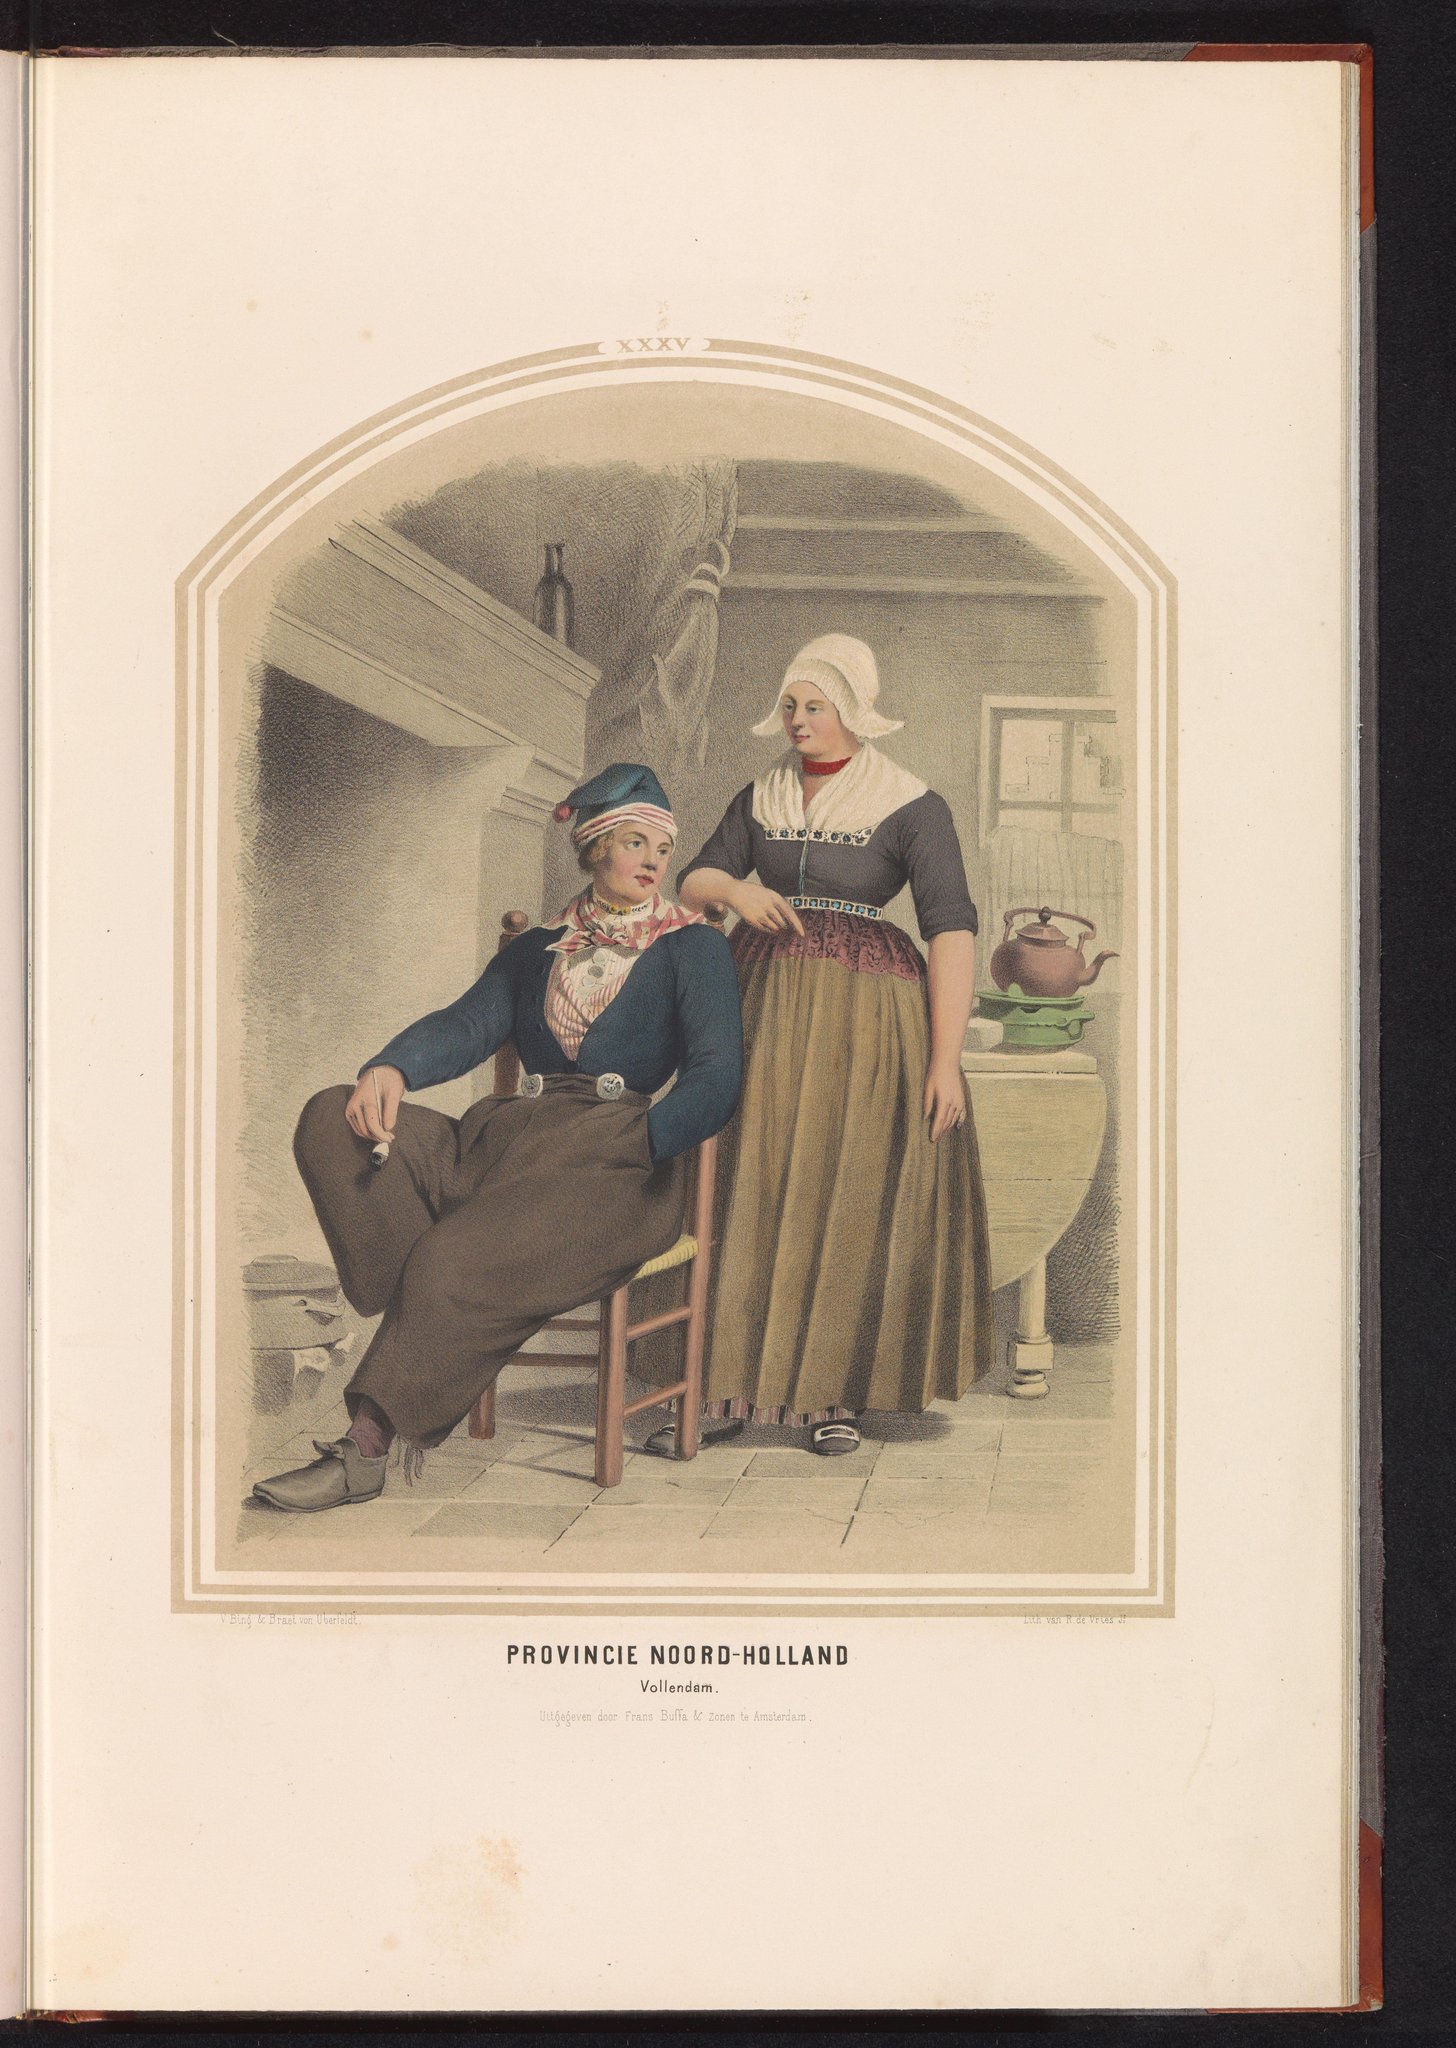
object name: costume print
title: Klederdracht van Volendam in Noord-Holland, 1857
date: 1857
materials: paper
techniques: hand coloring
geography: netherlands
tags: folk costume, regional costume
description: Klederdracht van de plaats Volendam in de provincie Noord-Holland. Man en vrouw bij de haard. Illustratie in een boek uit 1857 met 56 platen van Nederlandse klederdrachten.